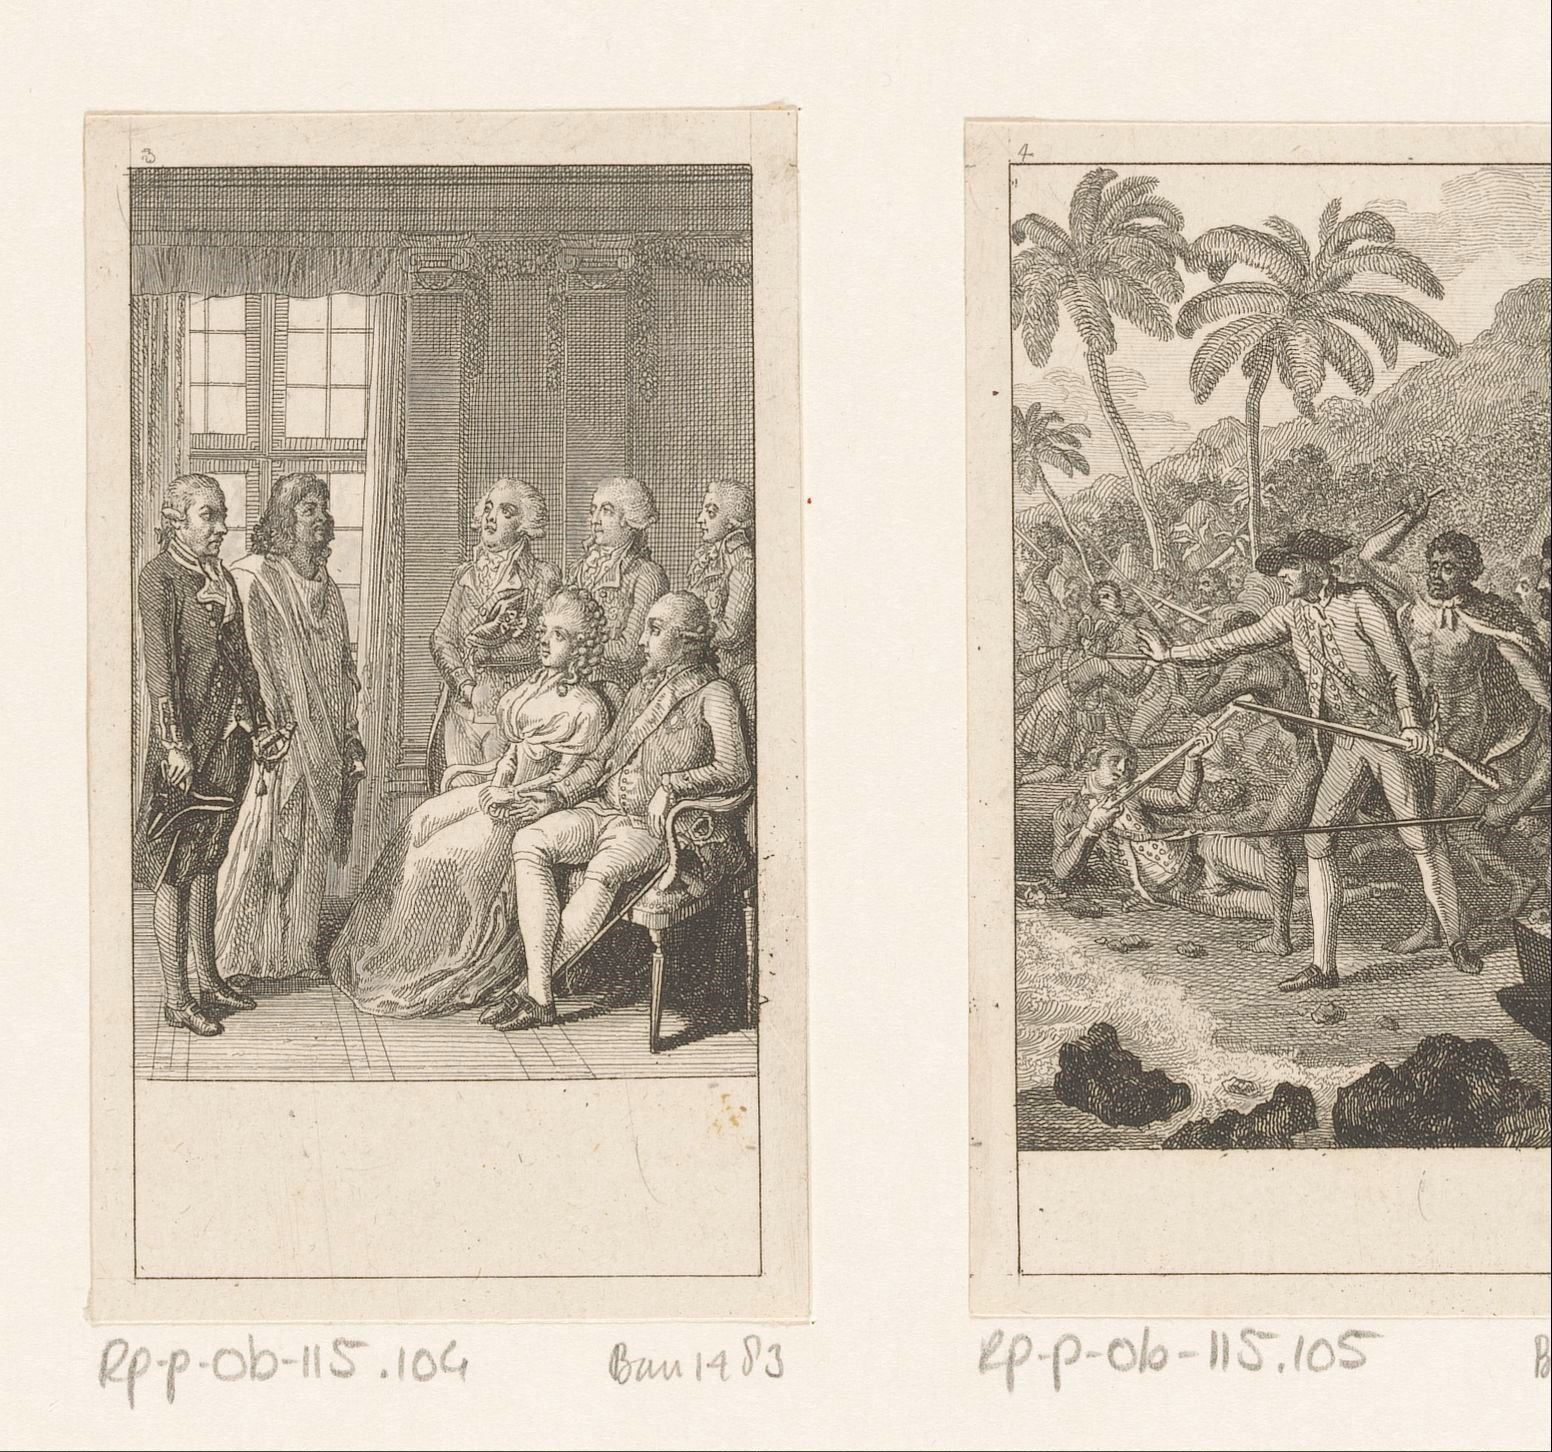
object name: print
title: James Cook op audiëntie bij George III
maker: daniel nikolaus chodowiecki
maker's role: draughtsman, print maker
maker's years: 1726-1801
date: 1790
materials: paper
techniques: etching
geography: berlin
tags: james cook, london, george iii (koning van het verenigd koninkrijk), history, audition; ruler giving audience, exploration, expedition, voyage of discovery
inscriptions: collector's mark: Lugt 2228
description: Latere staat gebruikt voor: Gothaischer Hof Kalender zum Nutzen und Vergnügen eingerichtet auf das Jahr 1791. Gotha: C. W. Ettinger, [1790].